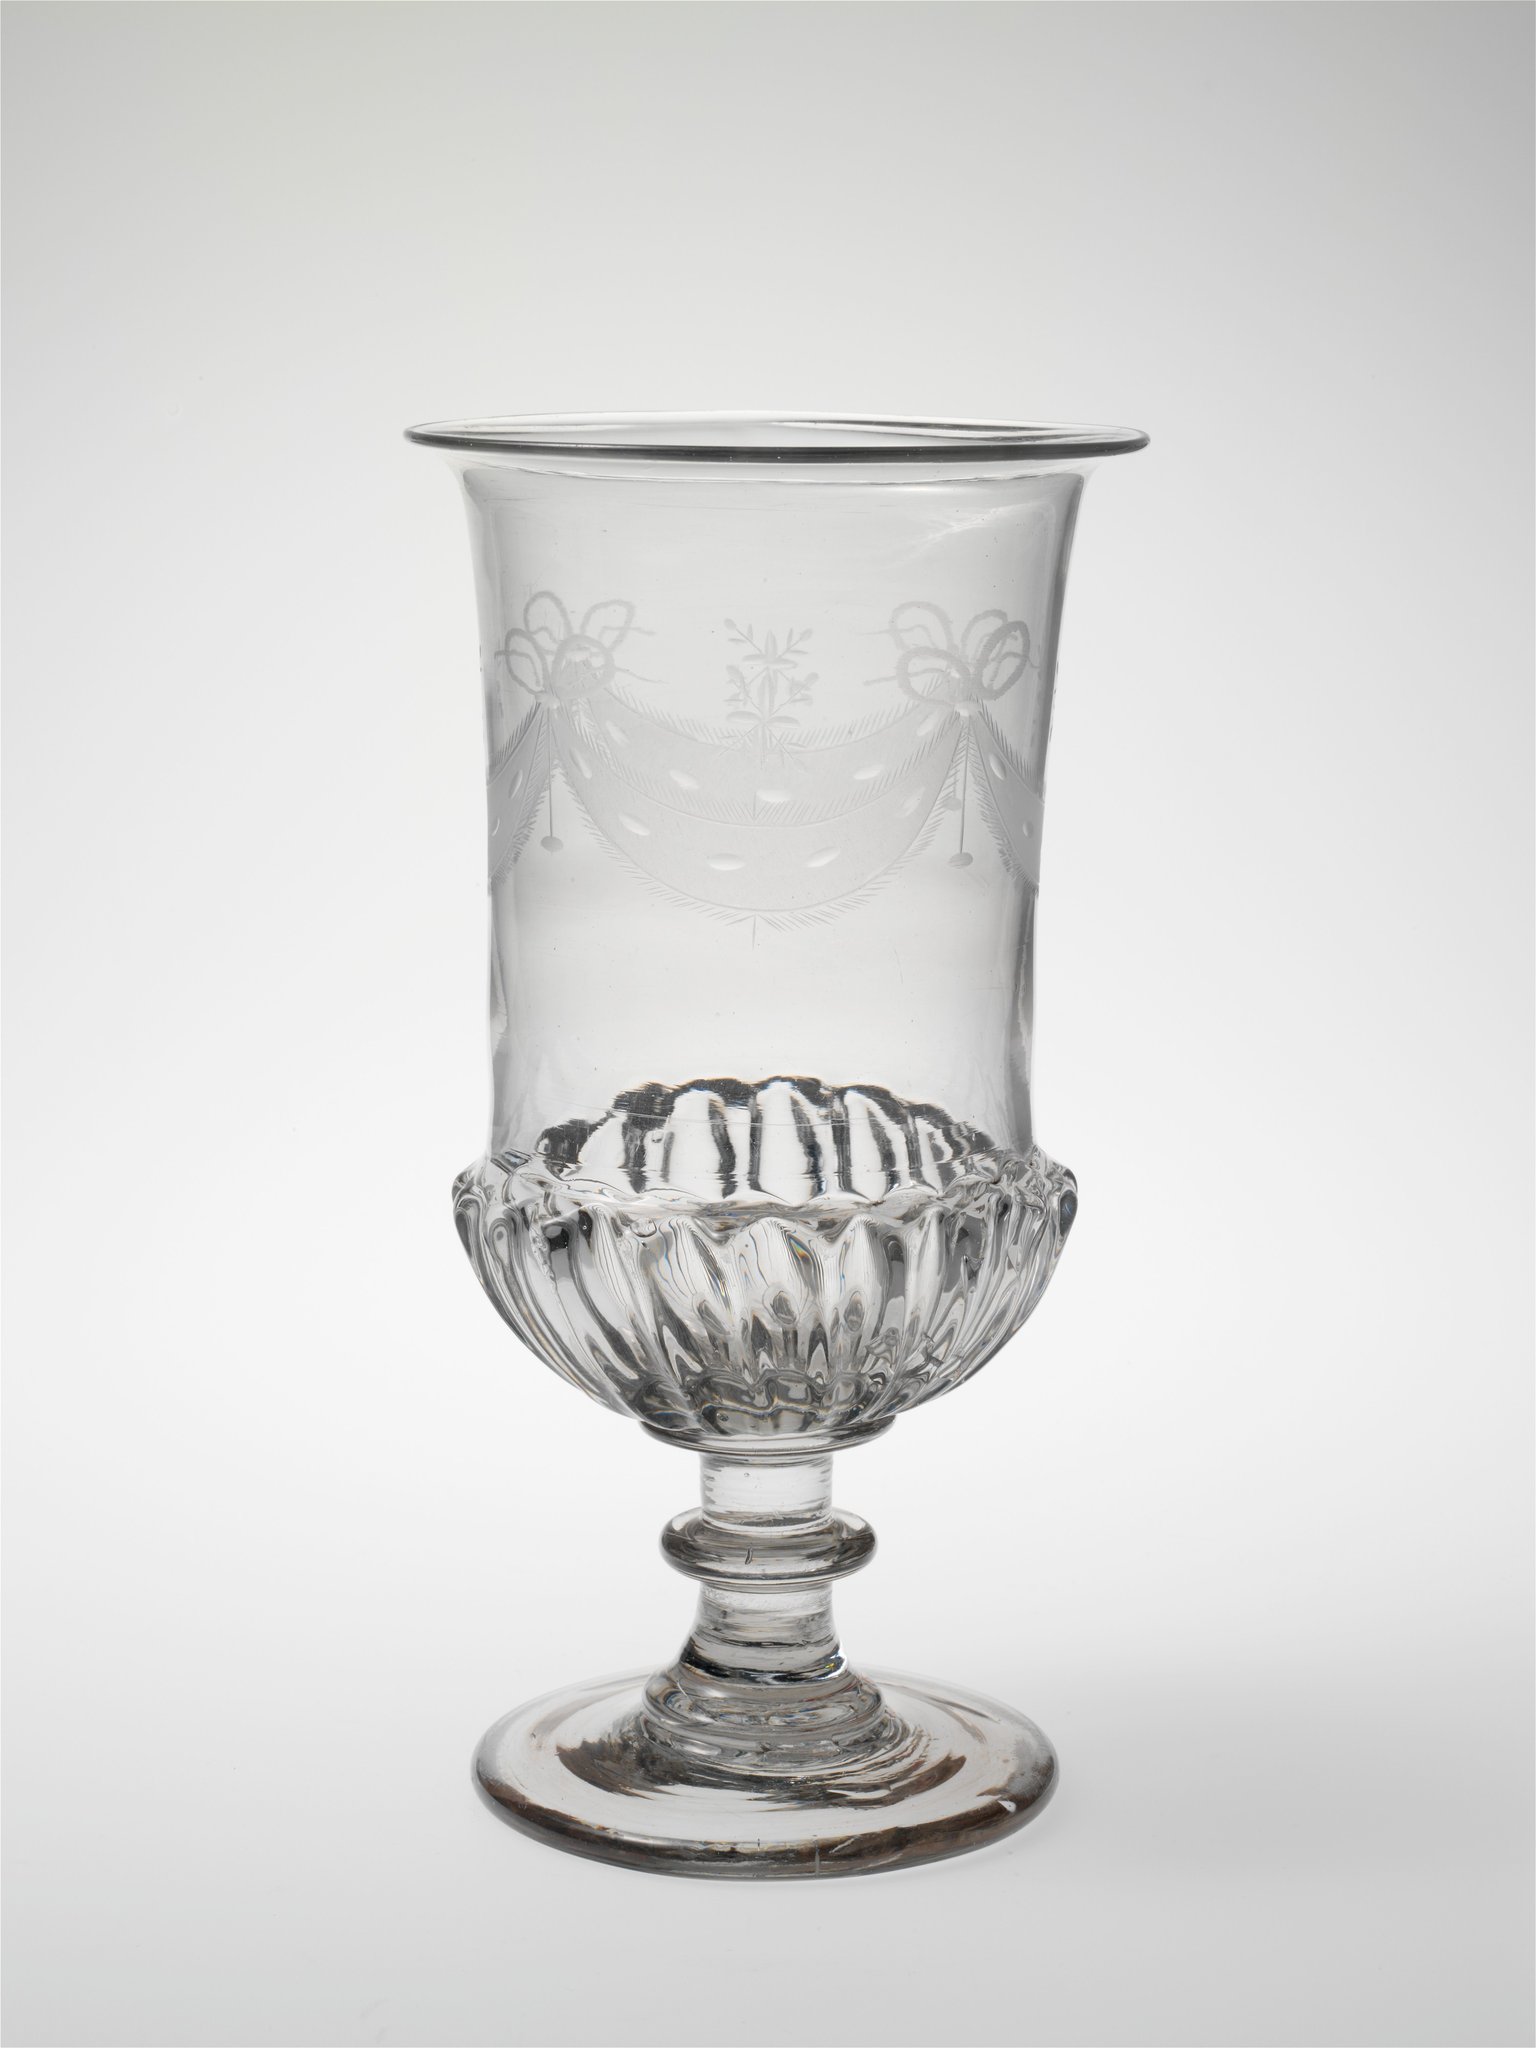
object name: celery vase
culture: american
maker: benjamin bakewell & co.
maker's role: maker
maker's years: 1809-1813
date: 1810-1820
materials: glass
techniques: glassblowing, engraving, molding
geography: united states